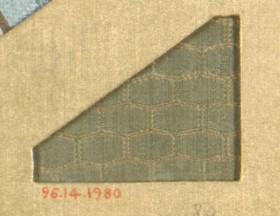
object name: piece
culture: japanese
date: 1701-1900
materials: silk